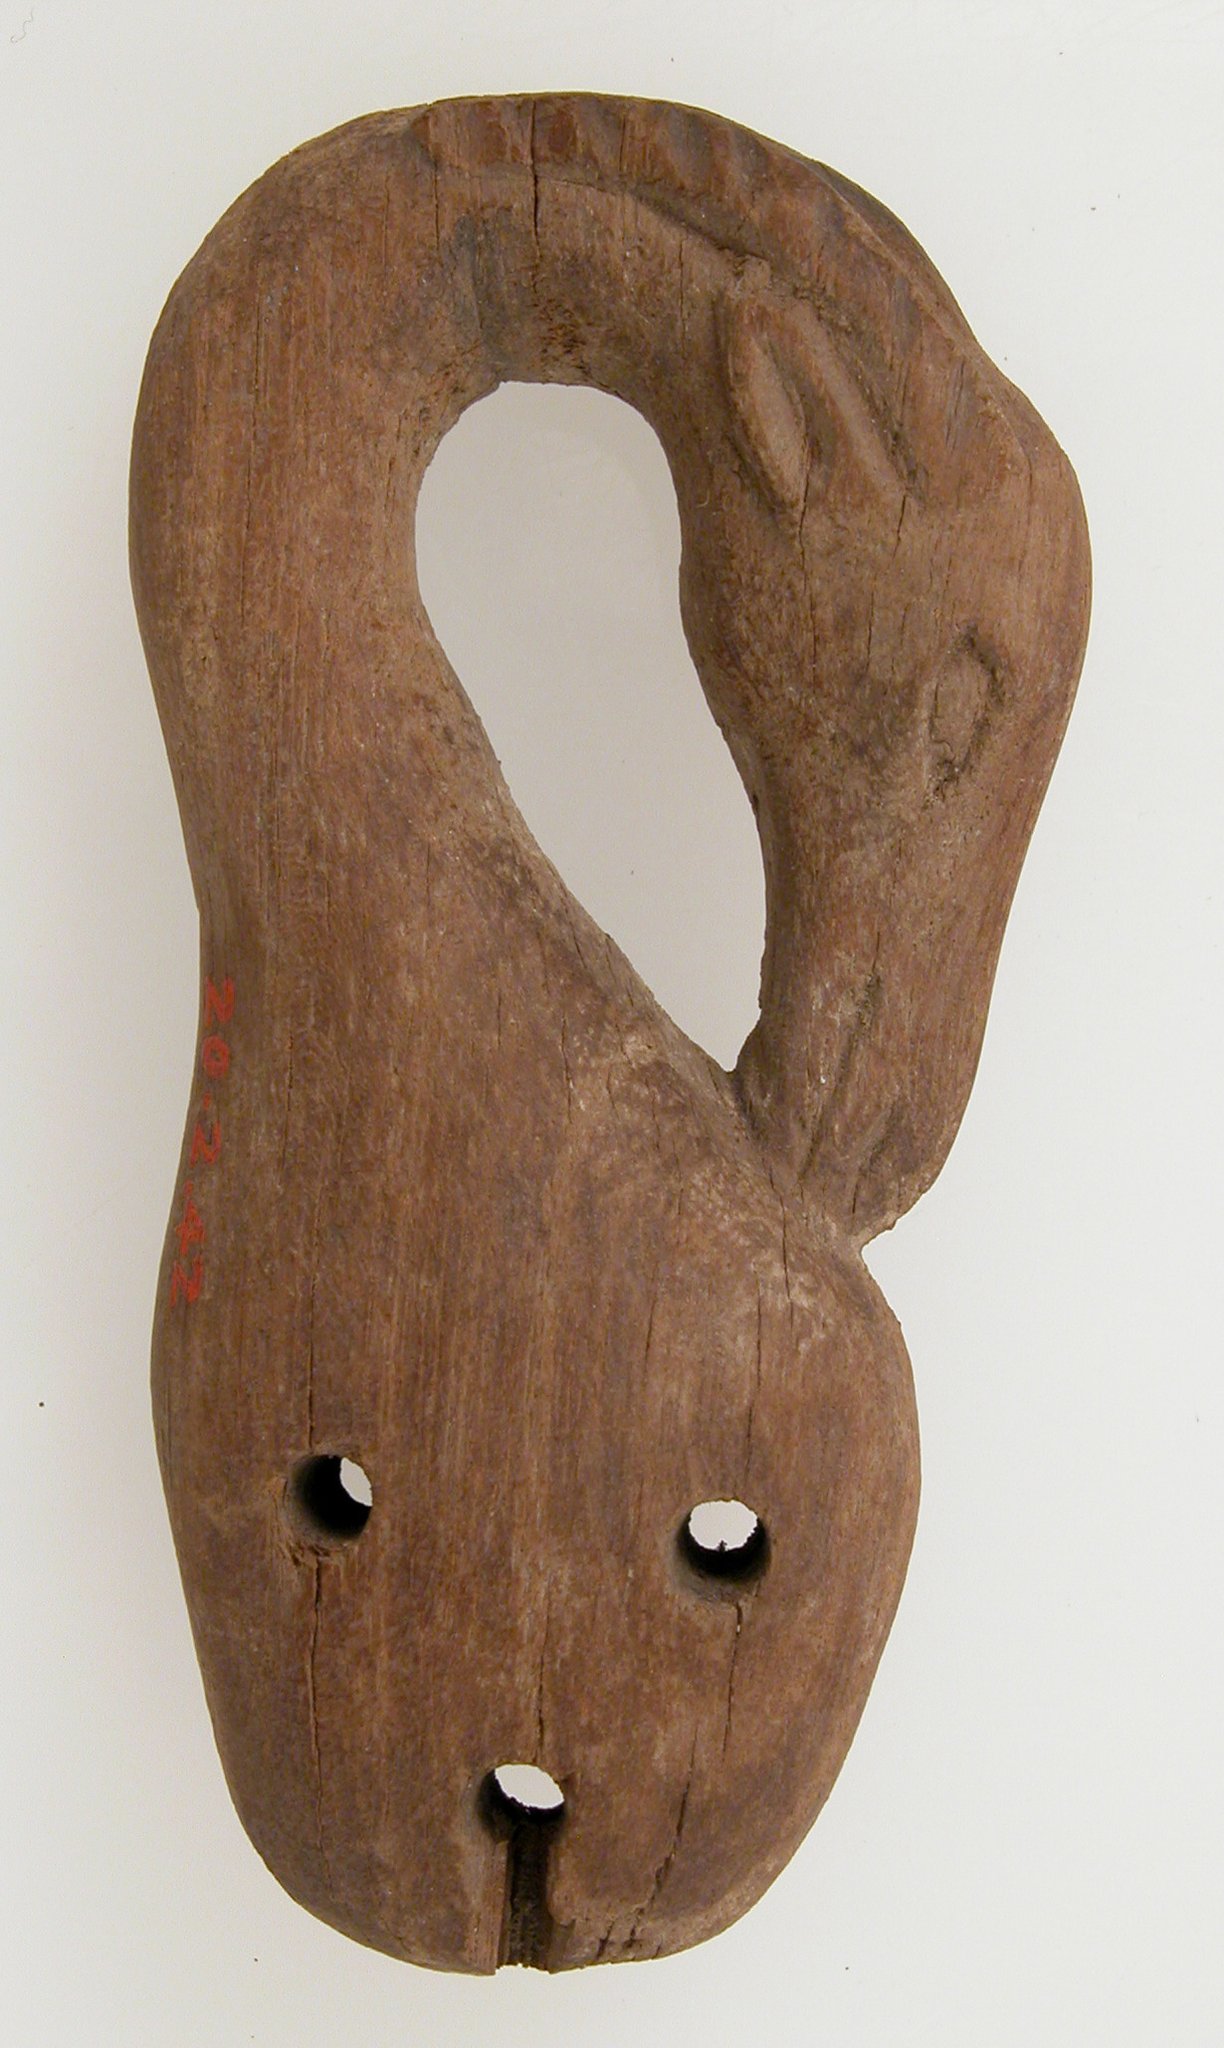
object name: pulley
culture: coptic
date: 201-500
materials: wood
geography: egypt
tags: animals